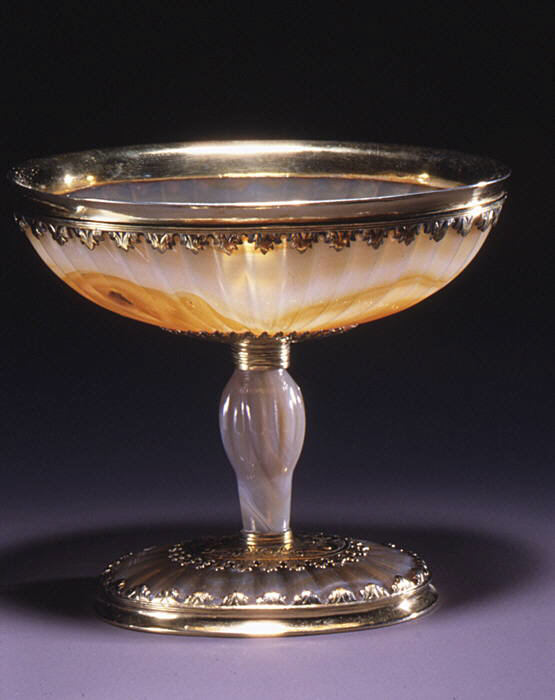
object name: cup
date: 1701-1733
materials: stone, silver gilt